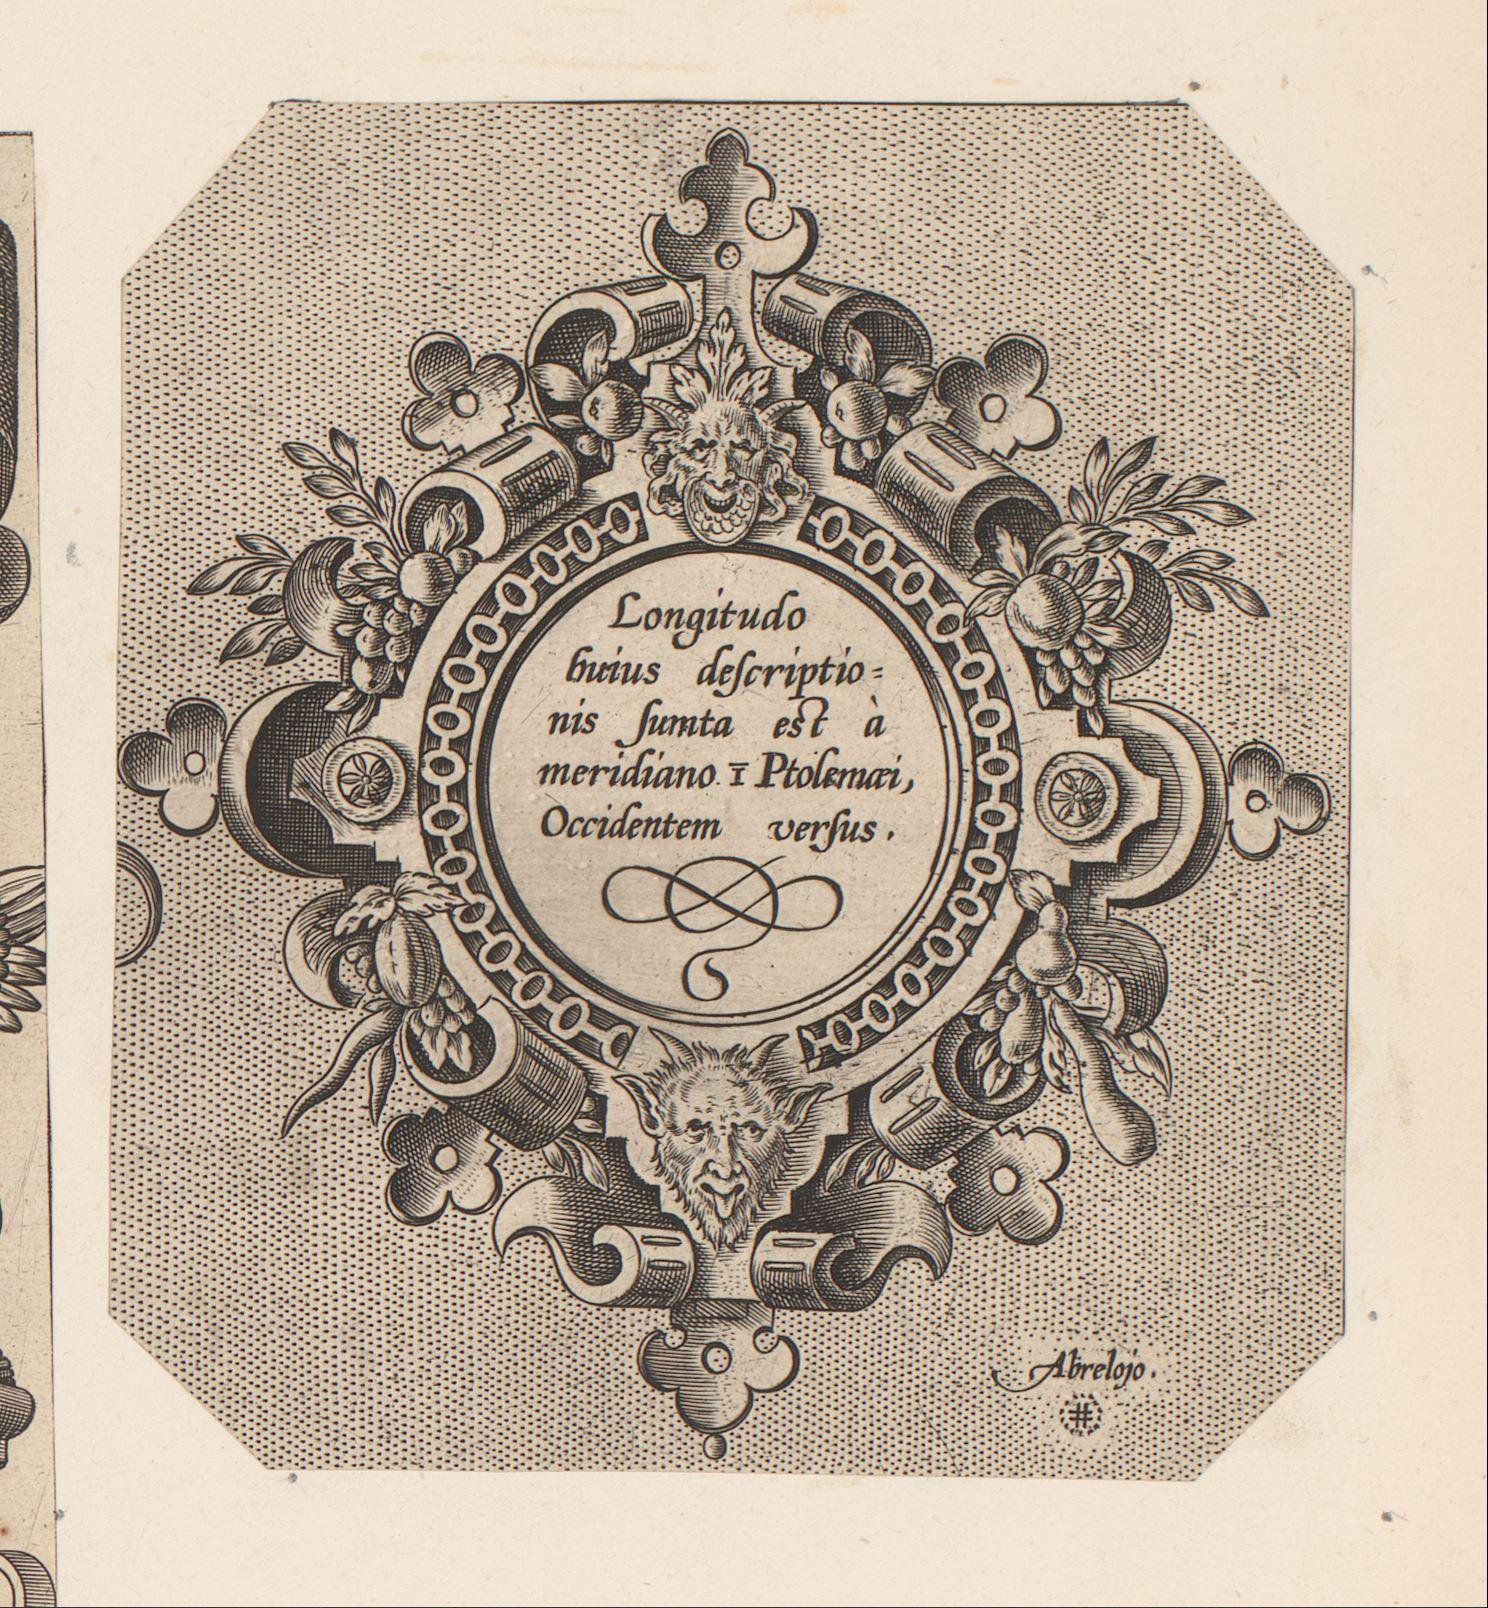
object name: ornament print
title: Ronde cartouche met twee saterskoppen en trossen fruit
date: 1584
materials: paper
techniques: engraving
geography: antwerp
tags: ornament ~ cartouche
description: Ronde cartouche met twee saterskoppen en trossen fruit. In de cartouche staat de tekst: Longitudo huius descriptionis sumta est à meridiano I Ptolemæi, Occidentem versus. De cartouche is een fragment van een kaart van de Azoren. De prent maakt deel uit van een album.